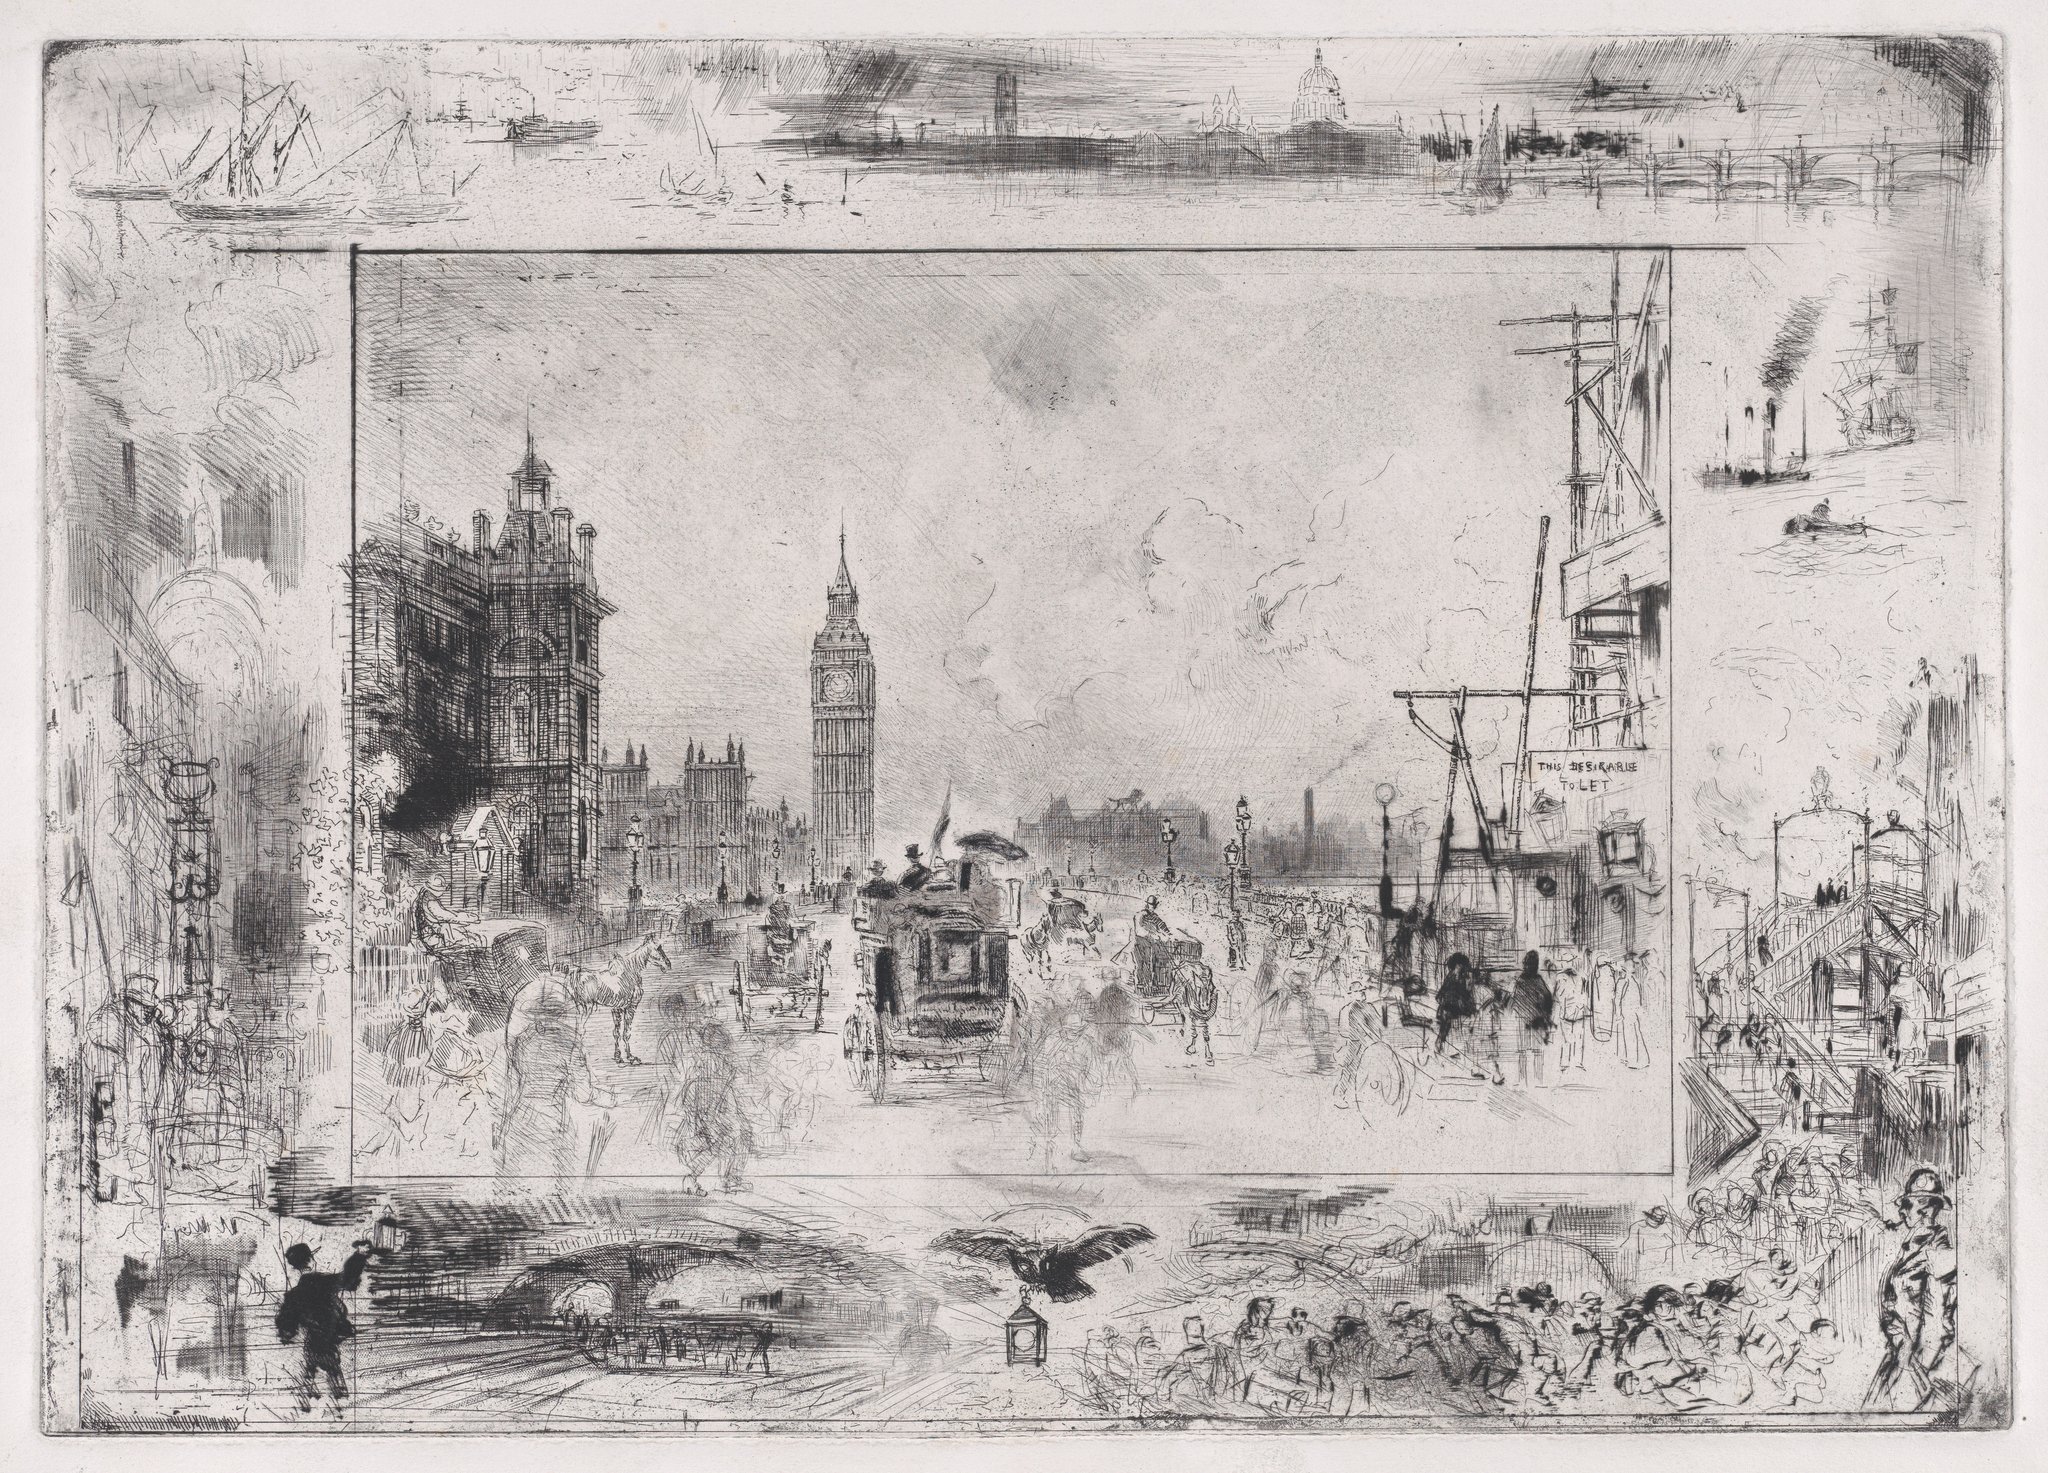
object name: print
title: Westminster Bridge, or Westminster Clock Tower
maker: félix-hilaire buhot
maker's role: artist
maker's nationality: french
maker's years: 1847-1898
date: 1860-1898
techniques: aquatint, drypoint, etching, roulette